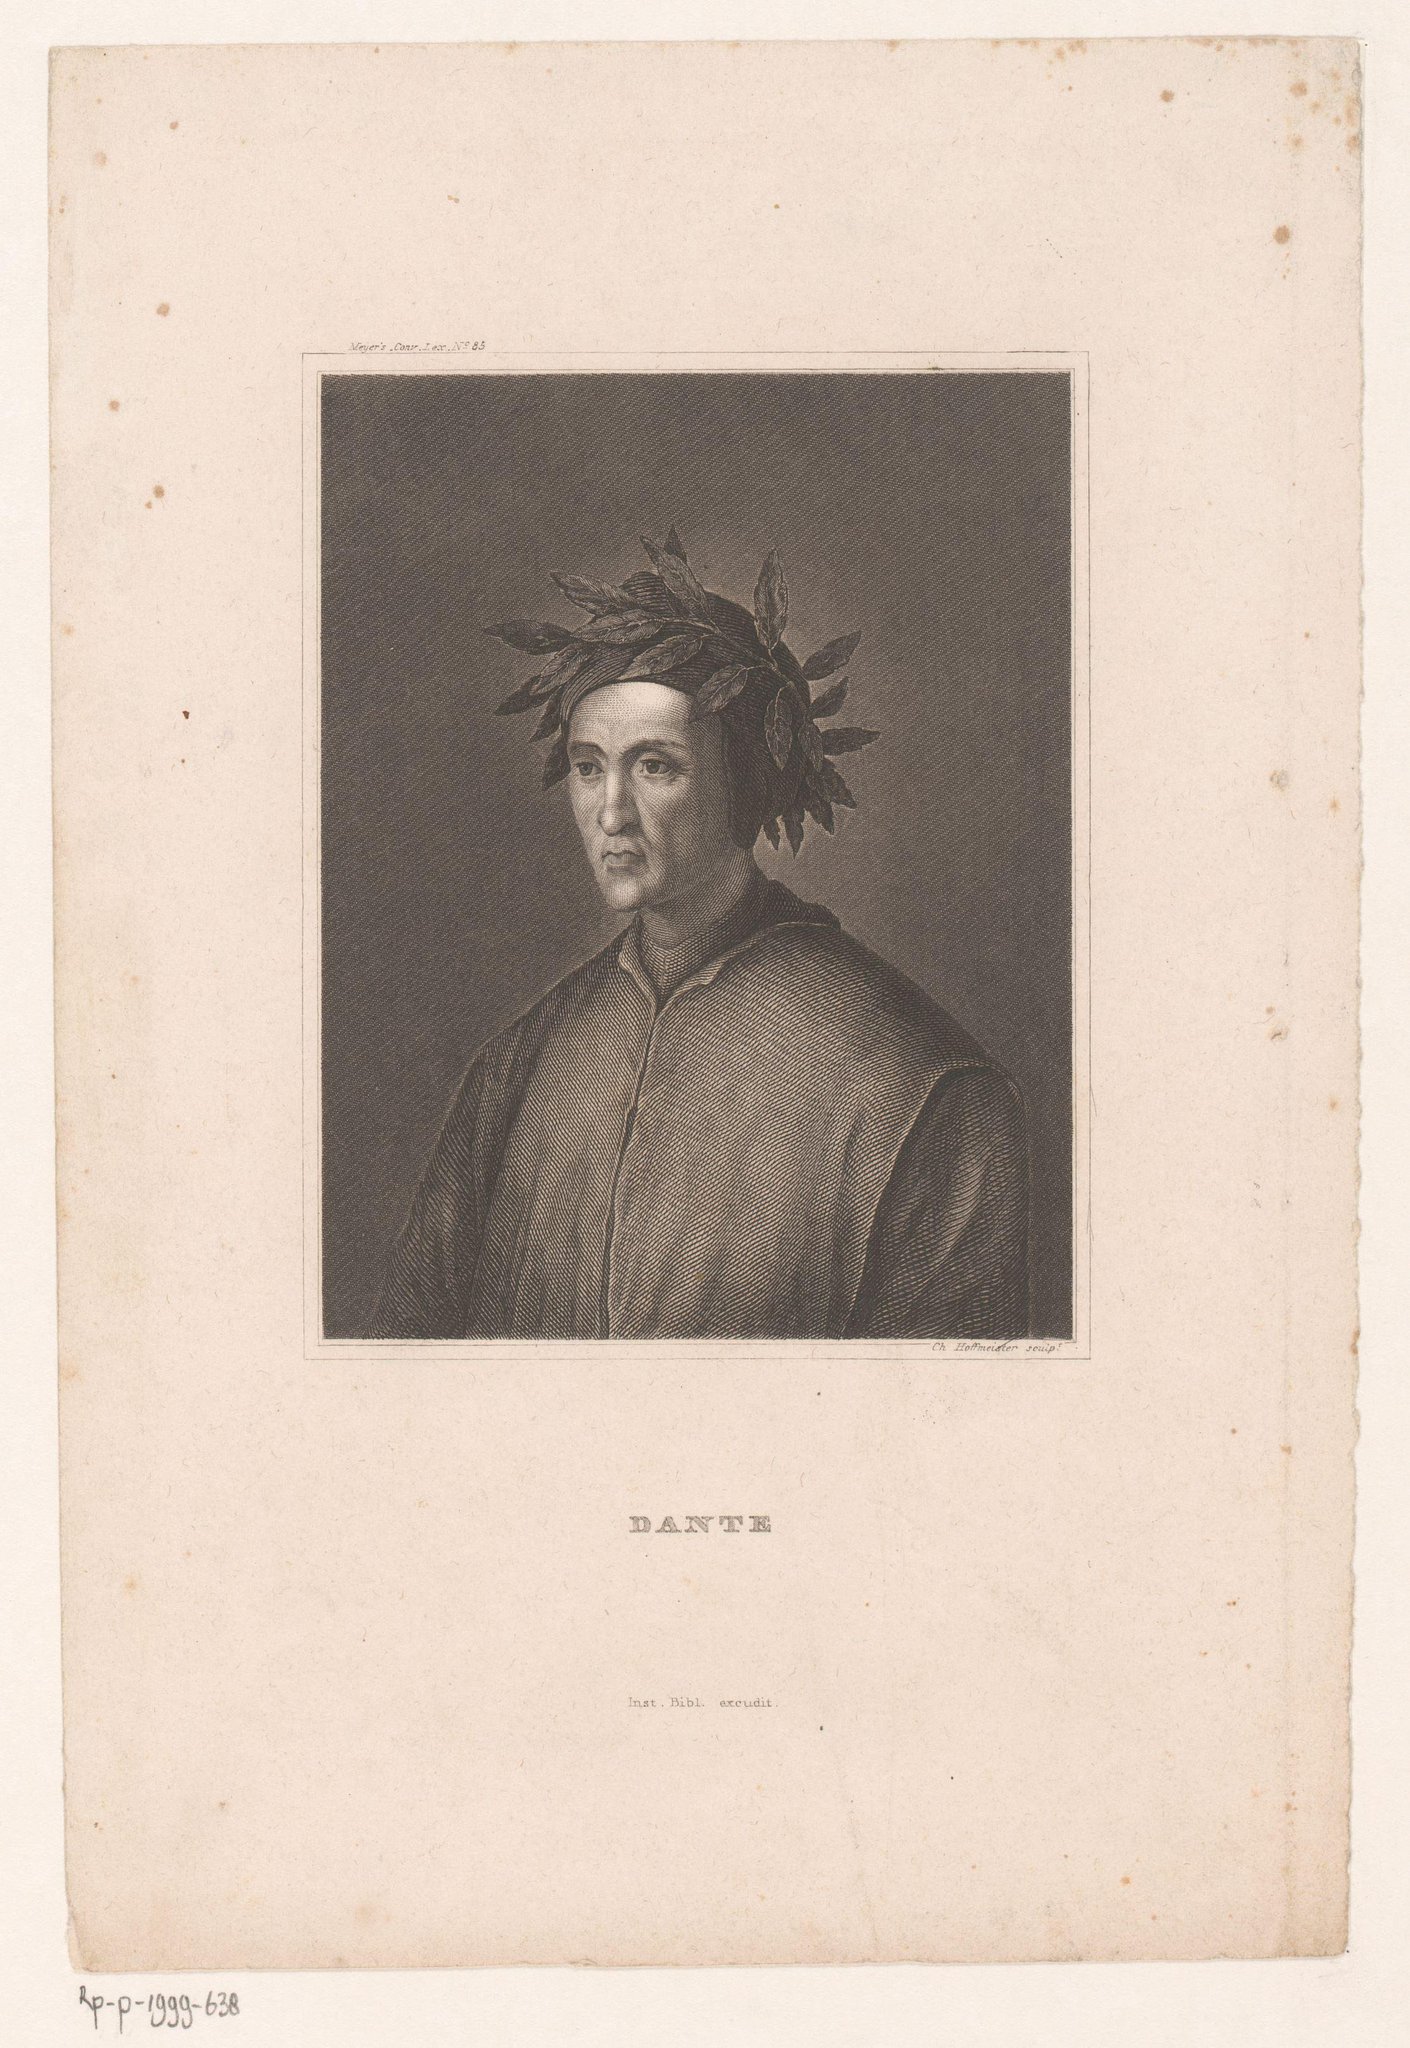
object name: book illustration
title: Portret van Dante Alighieri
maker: christian hoffmeister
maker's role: print maker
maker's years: 1818-1871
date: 1840-1855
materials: paper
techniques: engraving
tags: dante alighieri, historical persons, writer, poet, author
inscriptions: collector's mark: Lugt 2228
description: Prent afkomstig uit: Conversations-Lexikon für die gebildeten Stände, voor het eerst uitgegeven tussen 1840-1855.